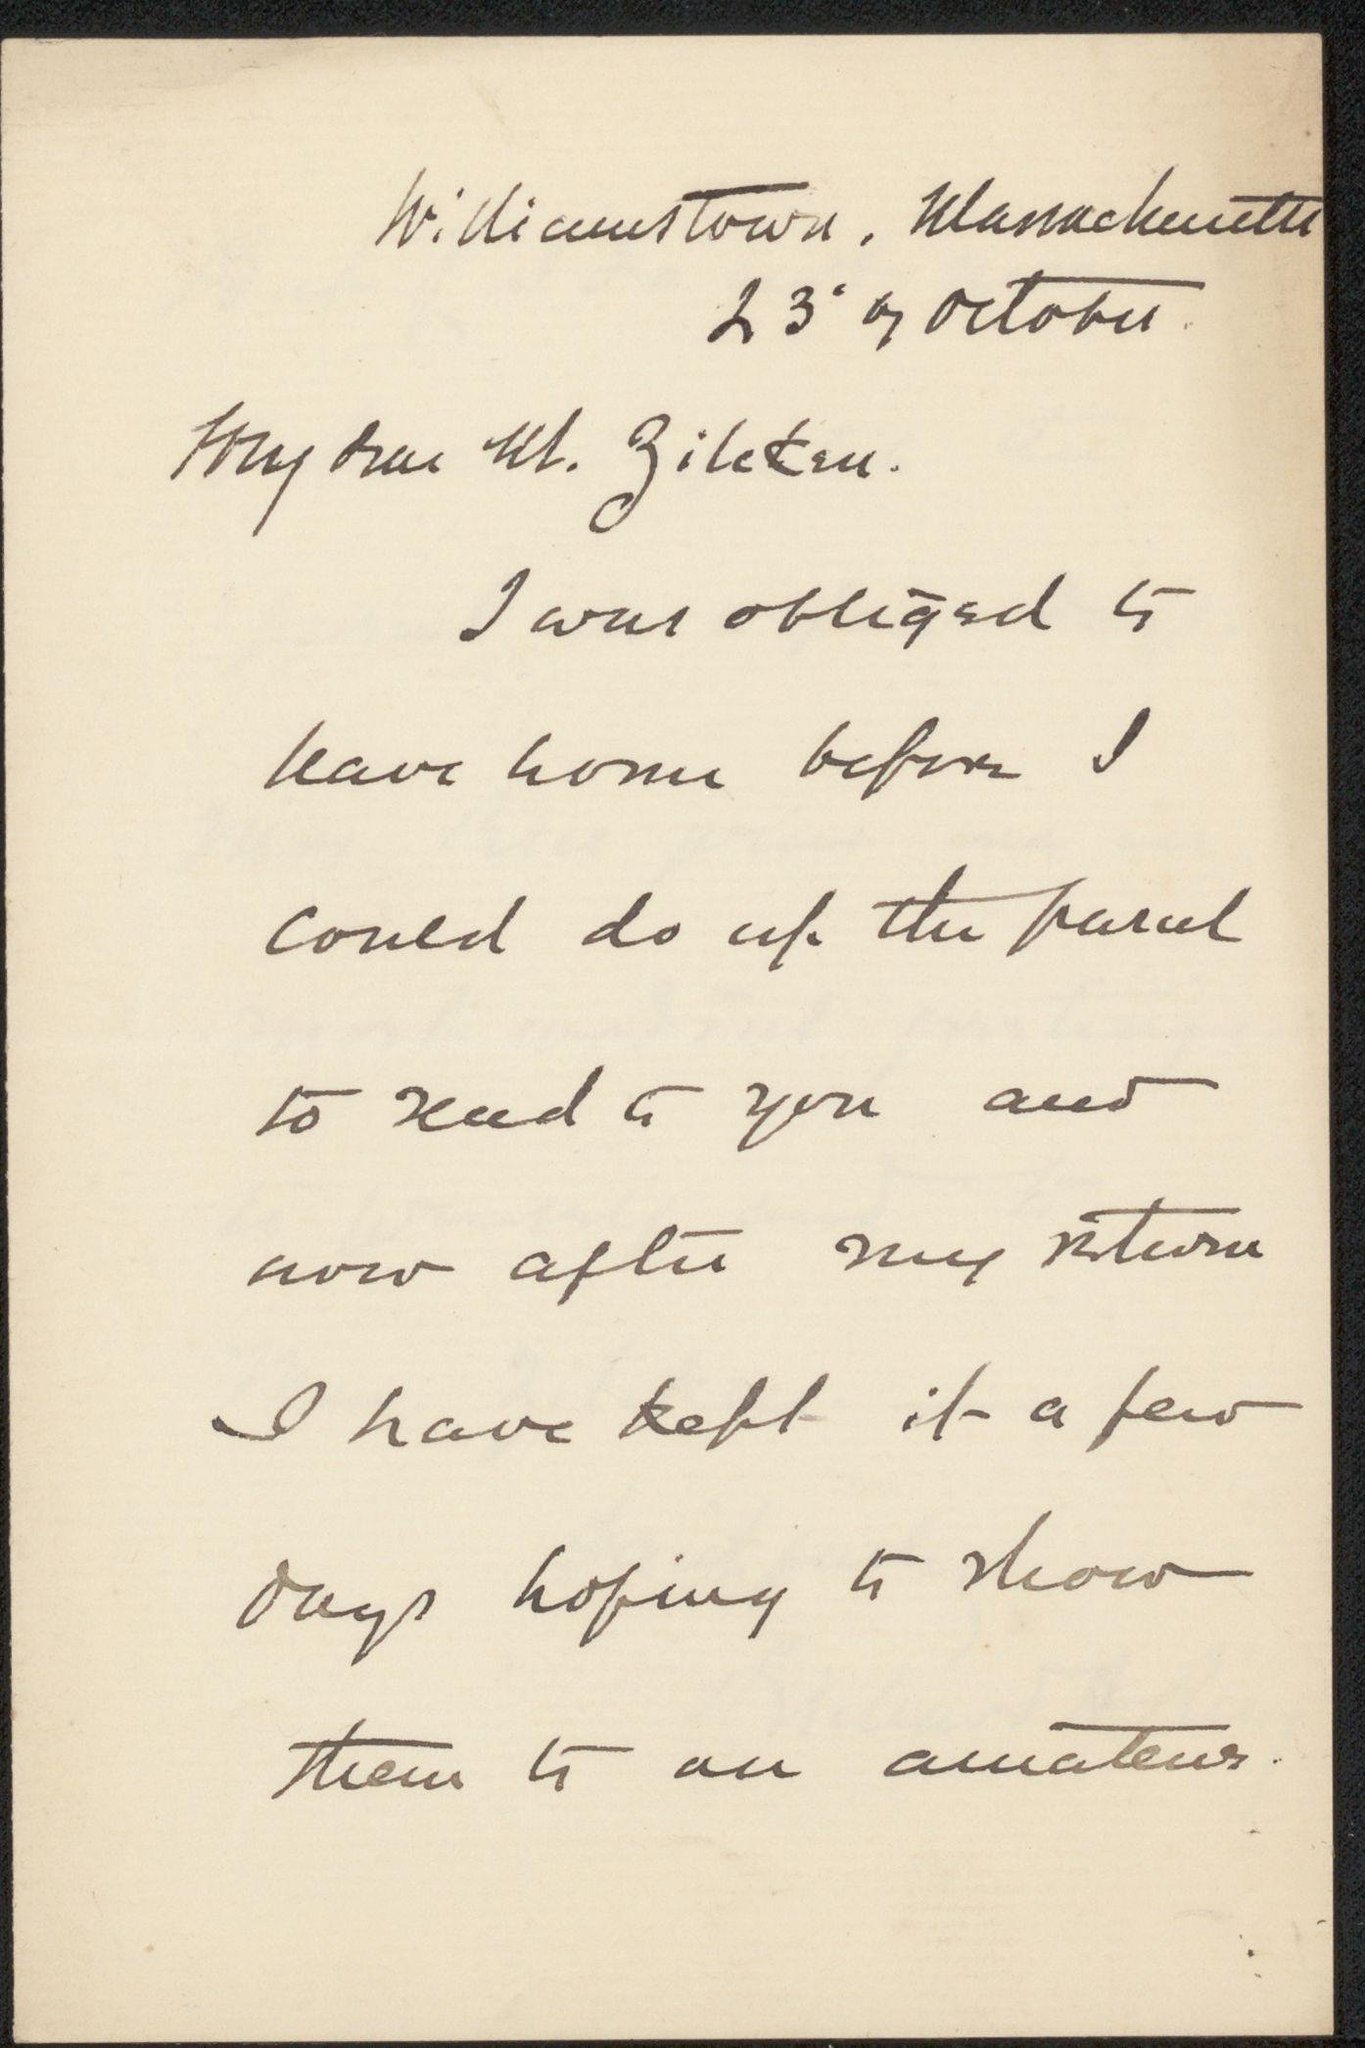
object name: letter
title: Brief aan Philip Zilcken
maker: richard austin rice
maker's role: professor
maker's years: 1846-1925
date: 1867-1925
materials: ink, paper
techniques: pen, writing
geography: williamstown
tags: painter, philip zilcken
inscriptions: watermark